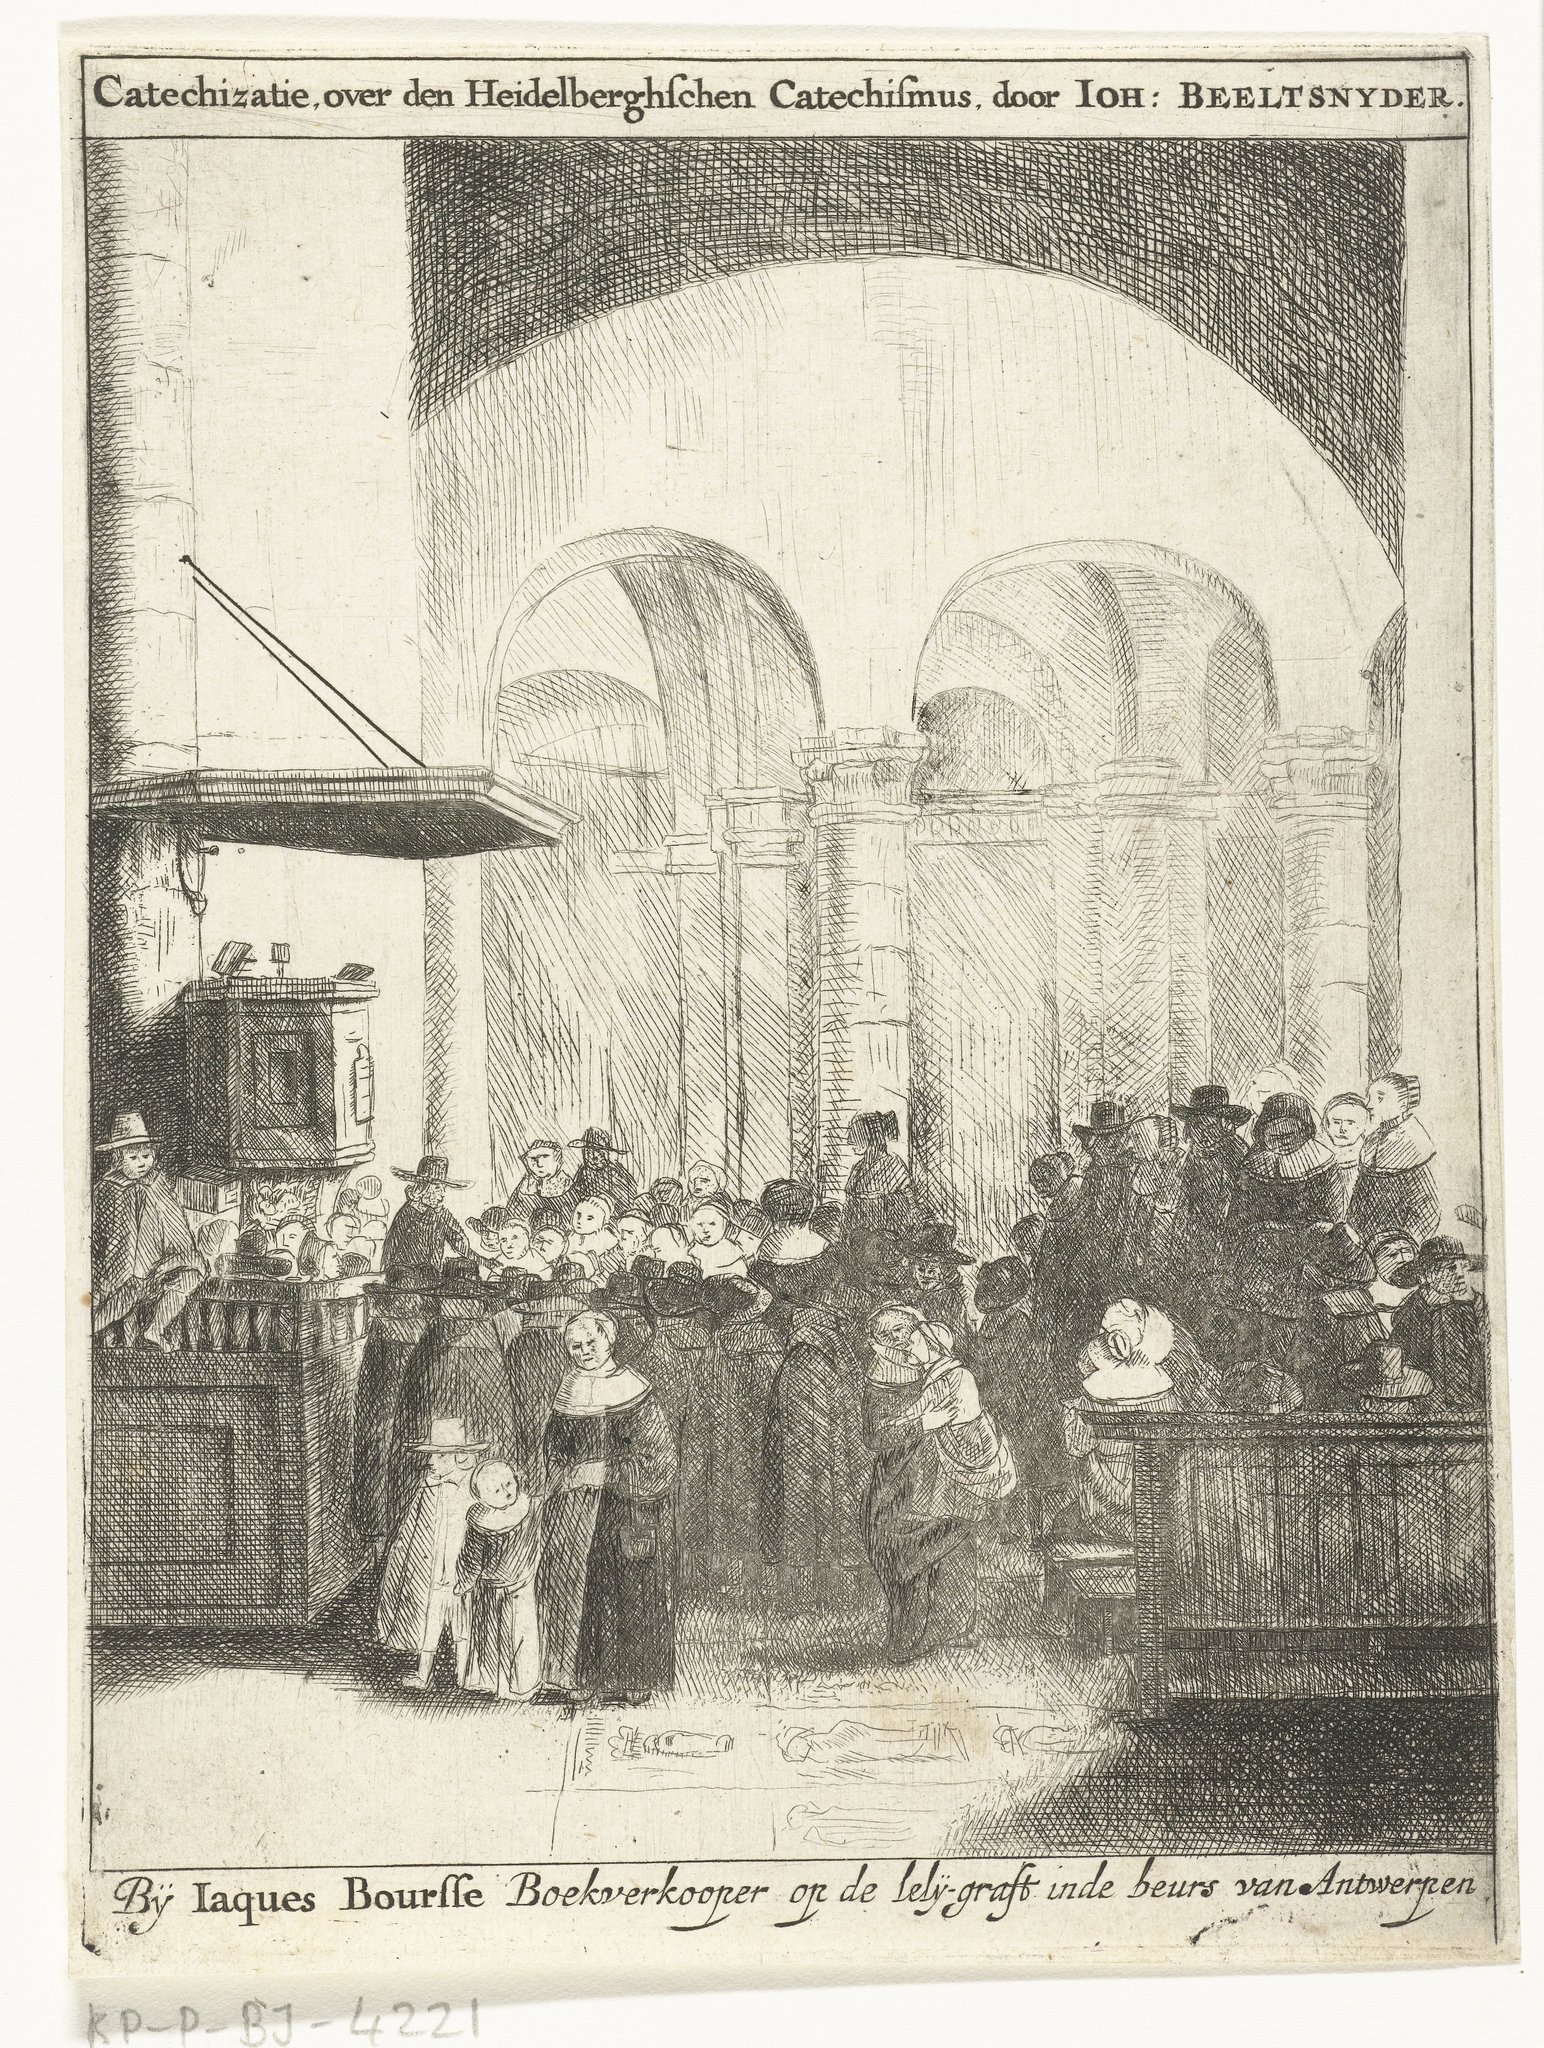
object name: titelblad, titelpagina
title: Kerkinterieur met kerkgangers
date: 1651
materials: paper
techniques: drypoint, engraving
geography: amsterdam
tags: interior of church, religious instruction of laity, e.g. sunday school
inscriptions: collector's mark: Lugt 240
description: In een kerk vindt een catechisatie plaats. De kerkgangers luisteren aandachtig naar de prediker Johannes Beeltsnyder. Twee vrouwen met kleine kinderen verlaten de kerk om de les niet te verstoren. Links zit een jongetje op een hoge houten afsluiting van de preekstoel.